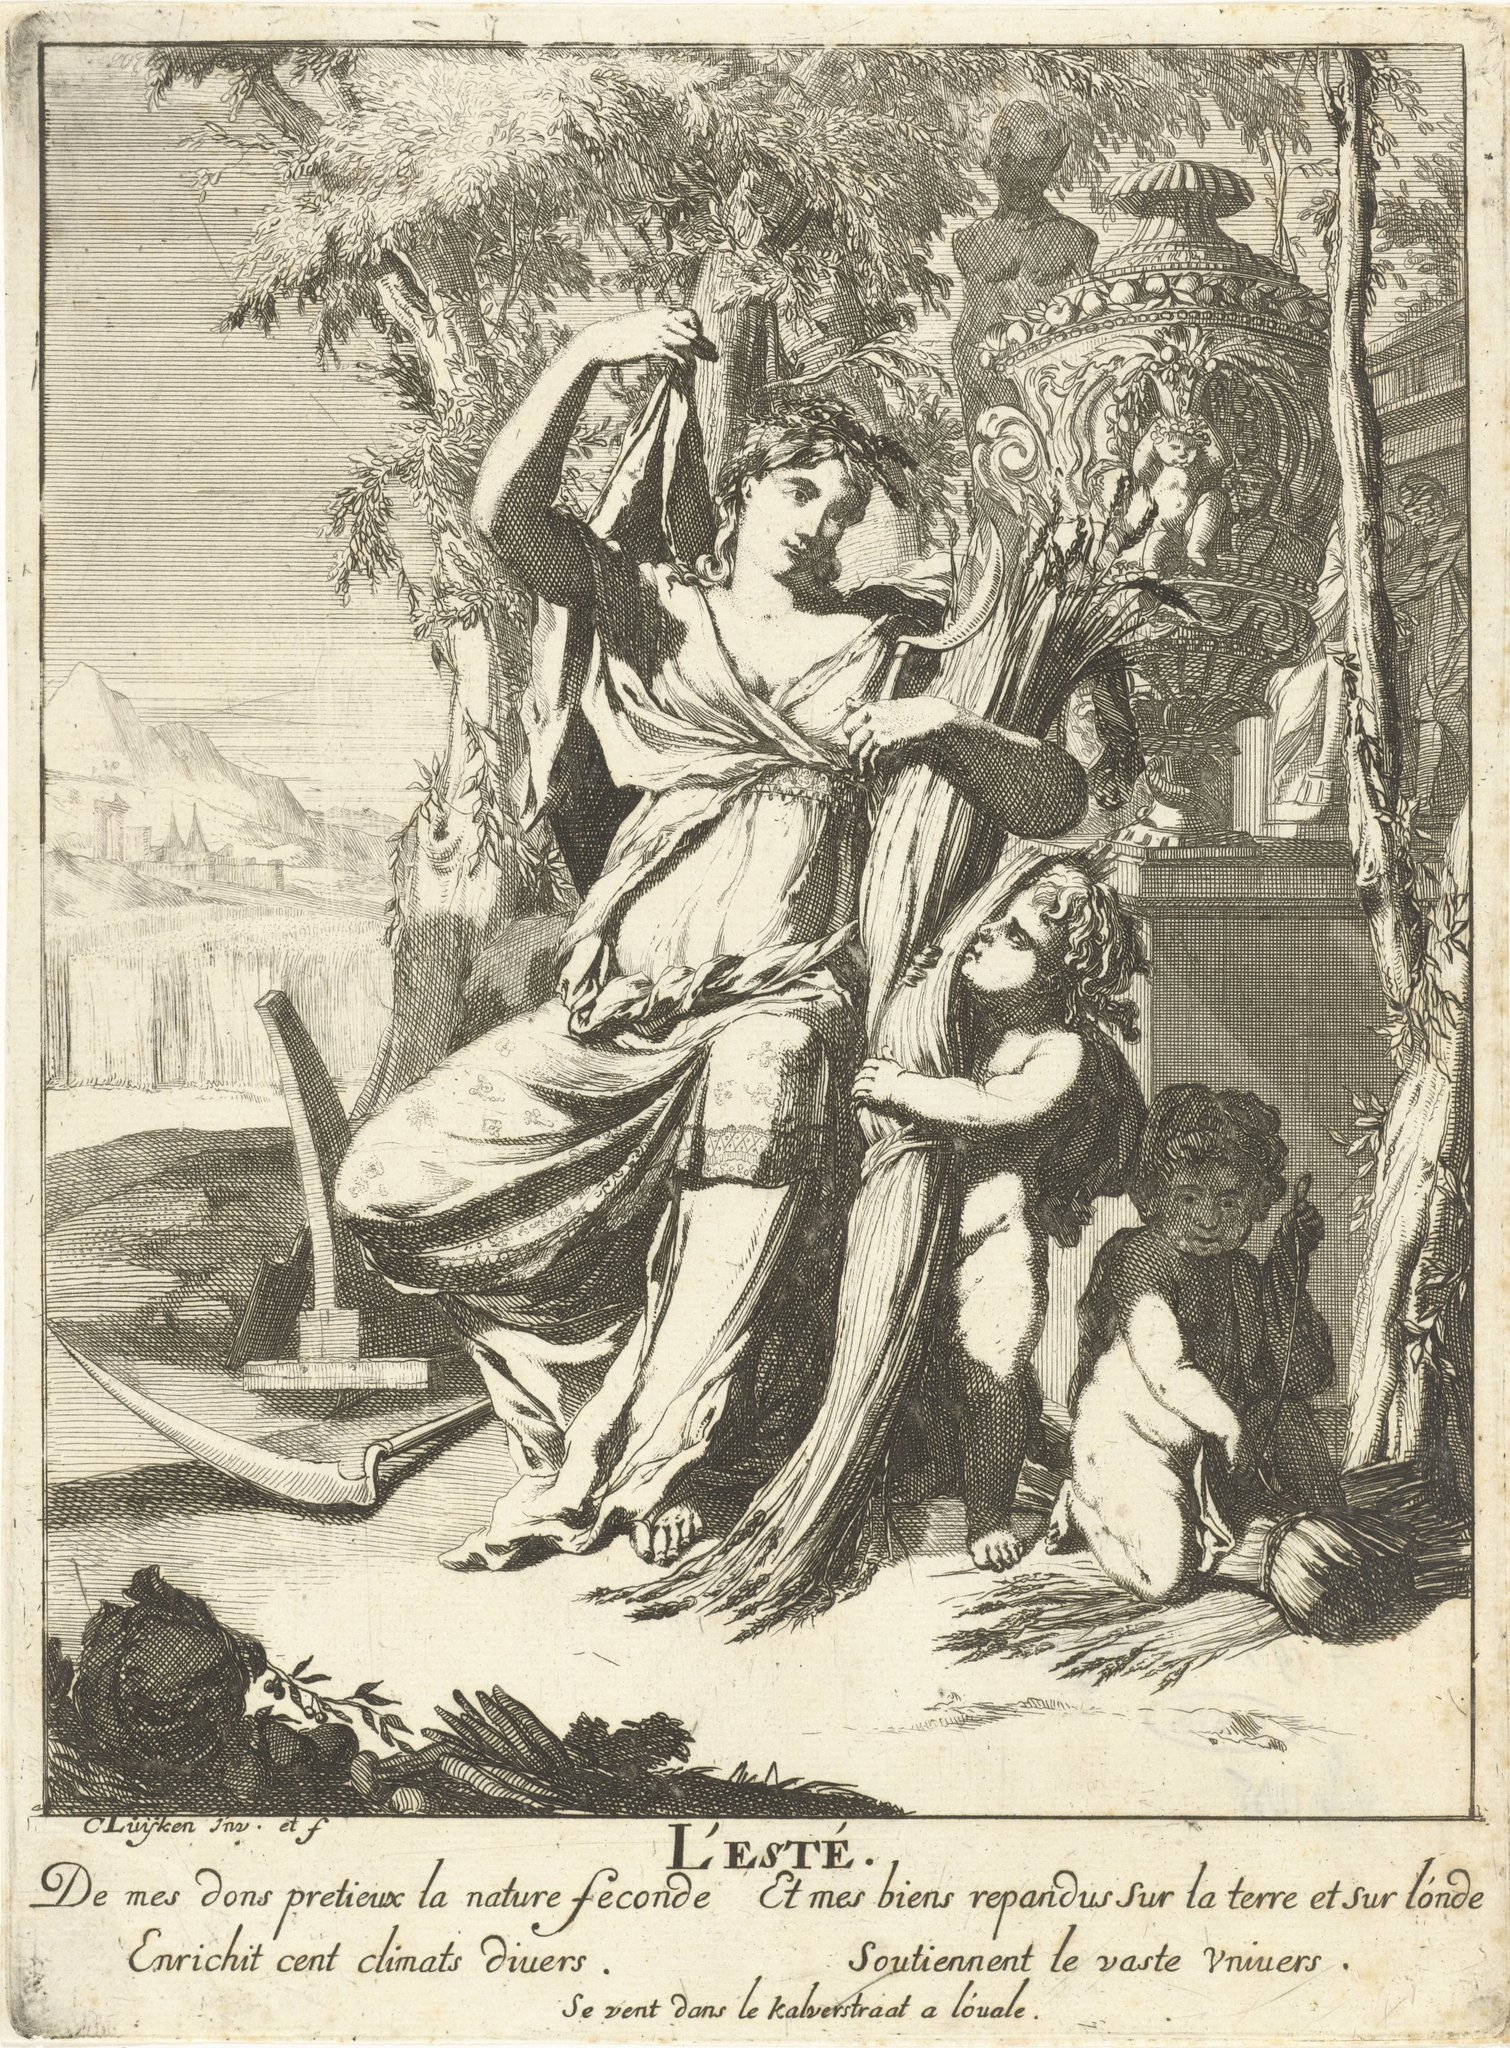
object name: print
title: De vier jaargetijden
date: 1698-1708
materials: paper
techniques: etching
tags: summer, 'aestas'; 'estate' (ripa)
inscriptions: collector's mark: Lugt 2228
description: Jonge vrouw met een korenschoof in haar armen, op de grond ligt een sikkel. Rechts van haar binden kinderen korenschoven bijeen. In de marge een vierregelig Frans vers op de zomer. De prent maakt deel uit van een vierdelige serie met voorstellingen van de vier jaargetijden.